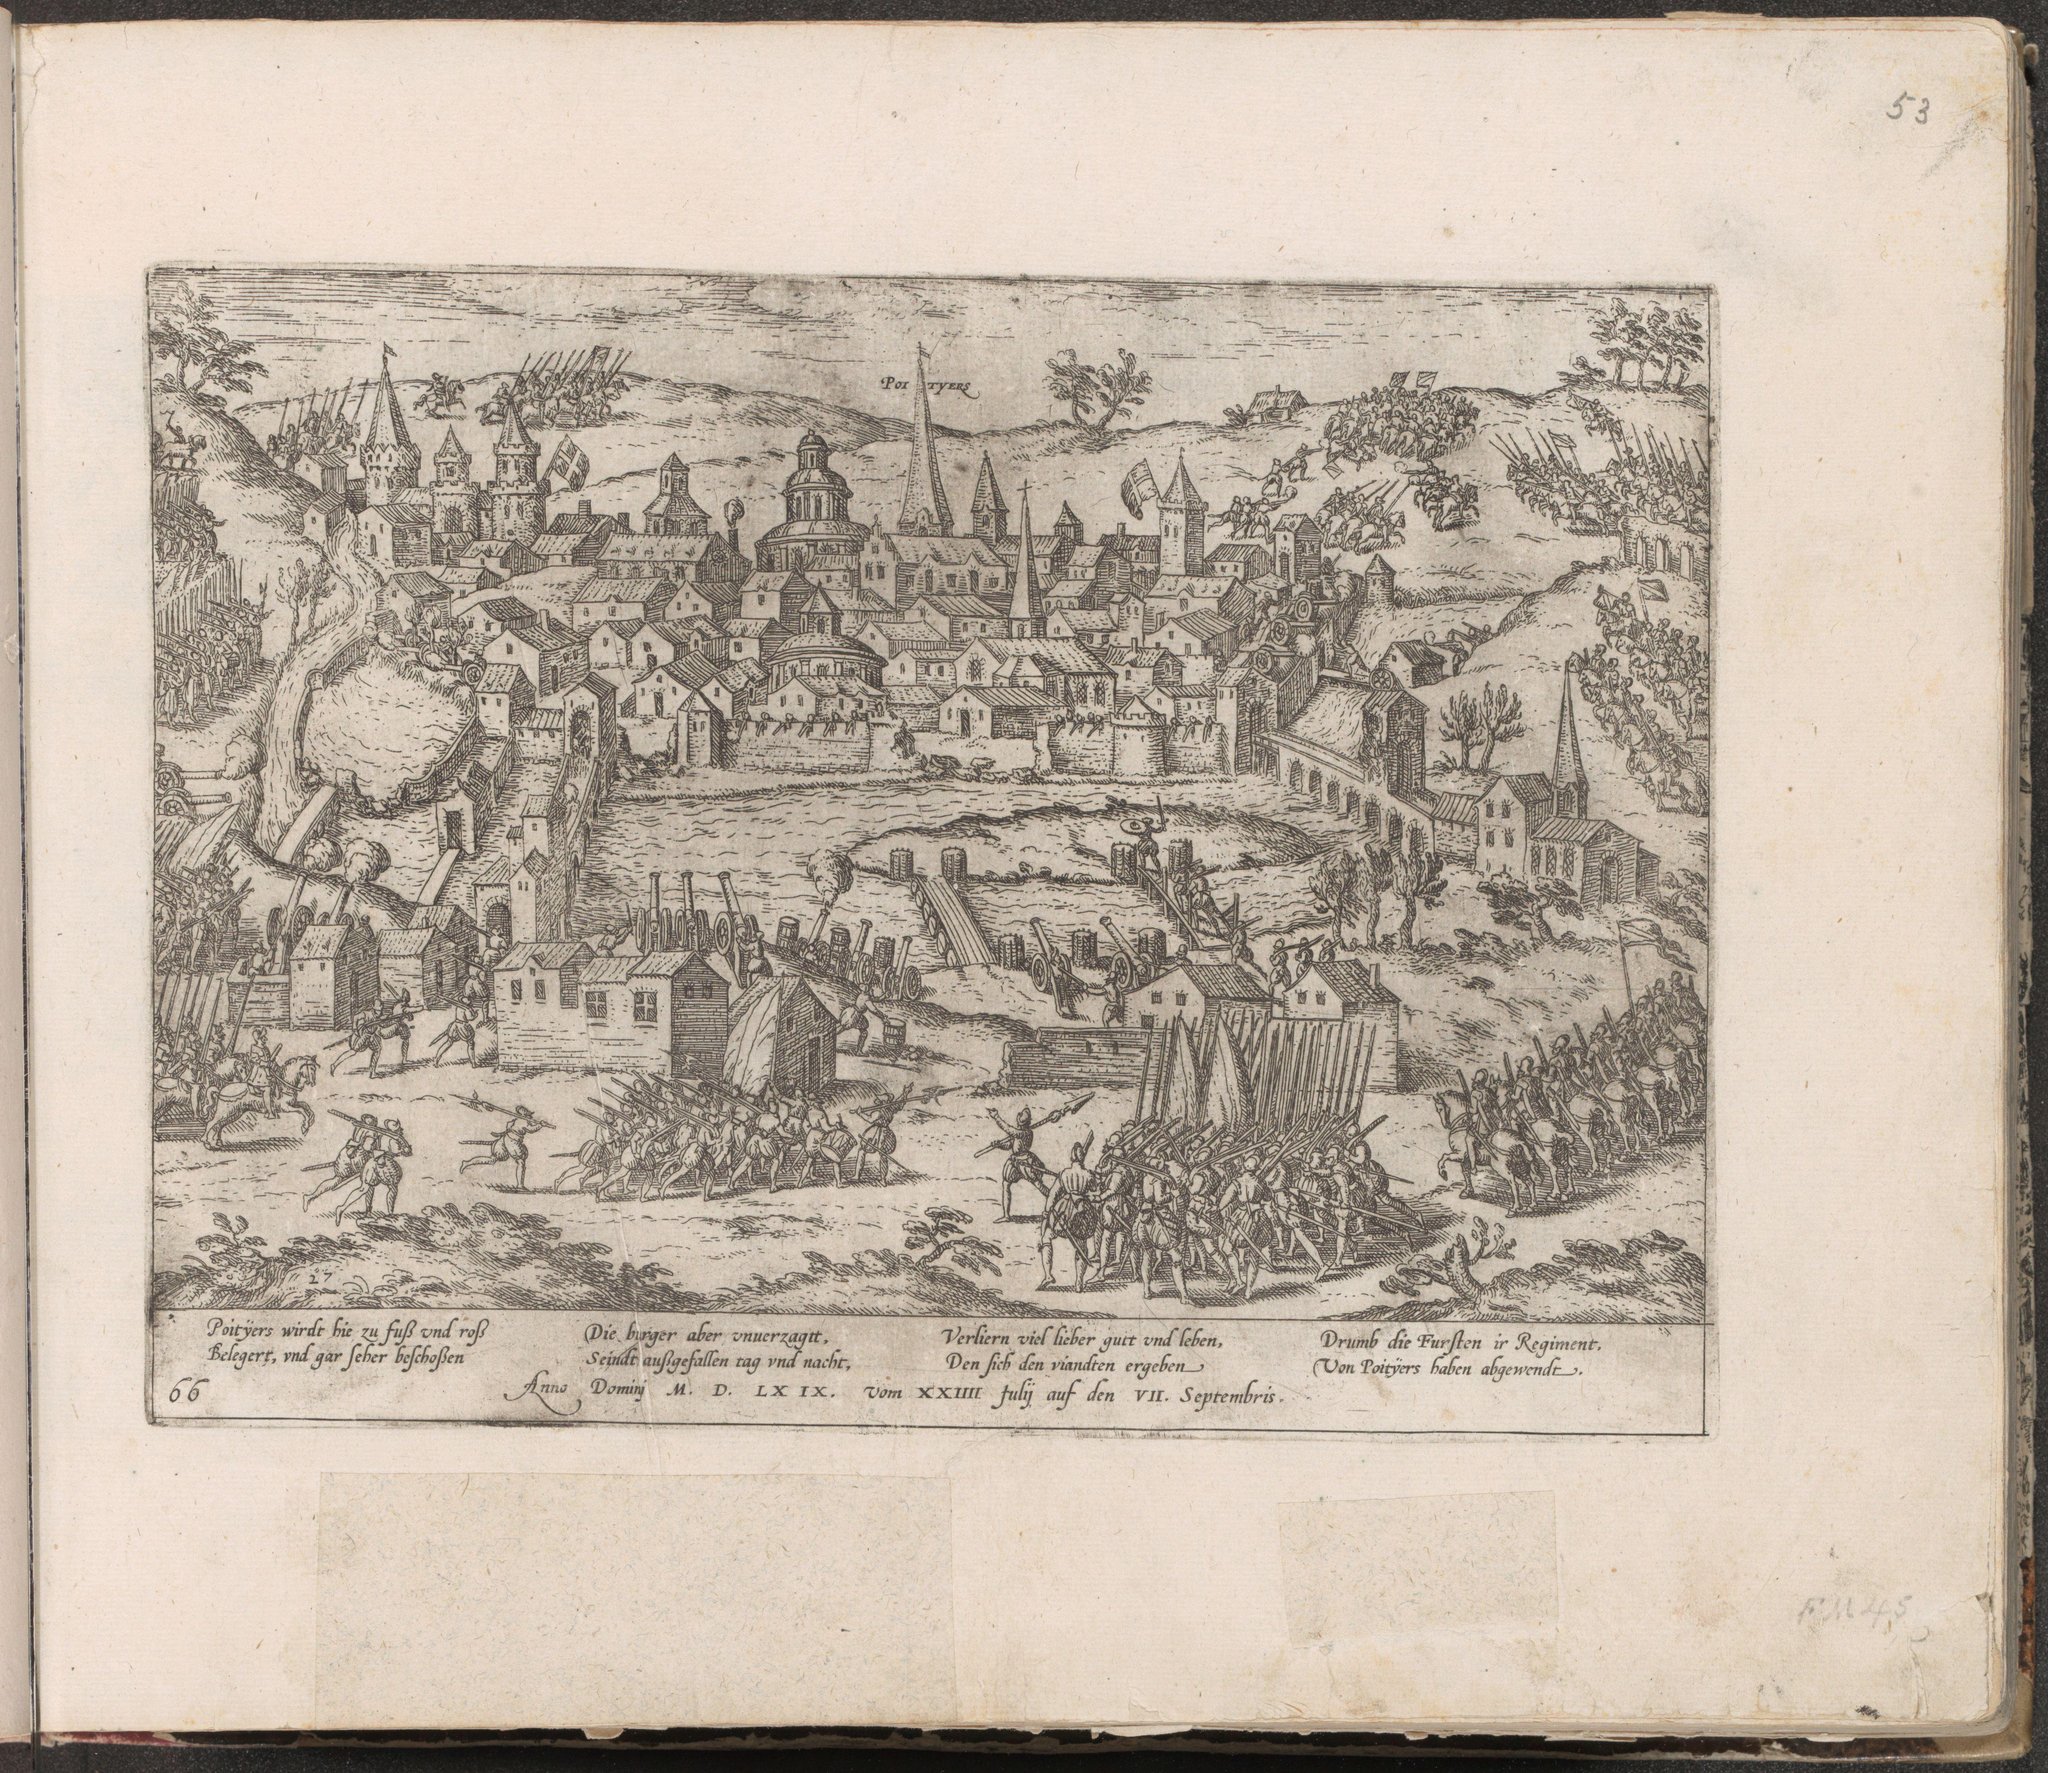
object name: print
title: Beleg van Poitiers, 1569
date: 1569-1571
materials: paper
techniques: etching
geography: cologne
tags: siege, position war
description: Beleg van Poitiers, 24 juli tot 7 september 1569. Gezicht op de belegerde stad. Met onderschrift van 8 regels in het Duits. Linksonder genummerd: 66. De prent maakt deel uit van een album.